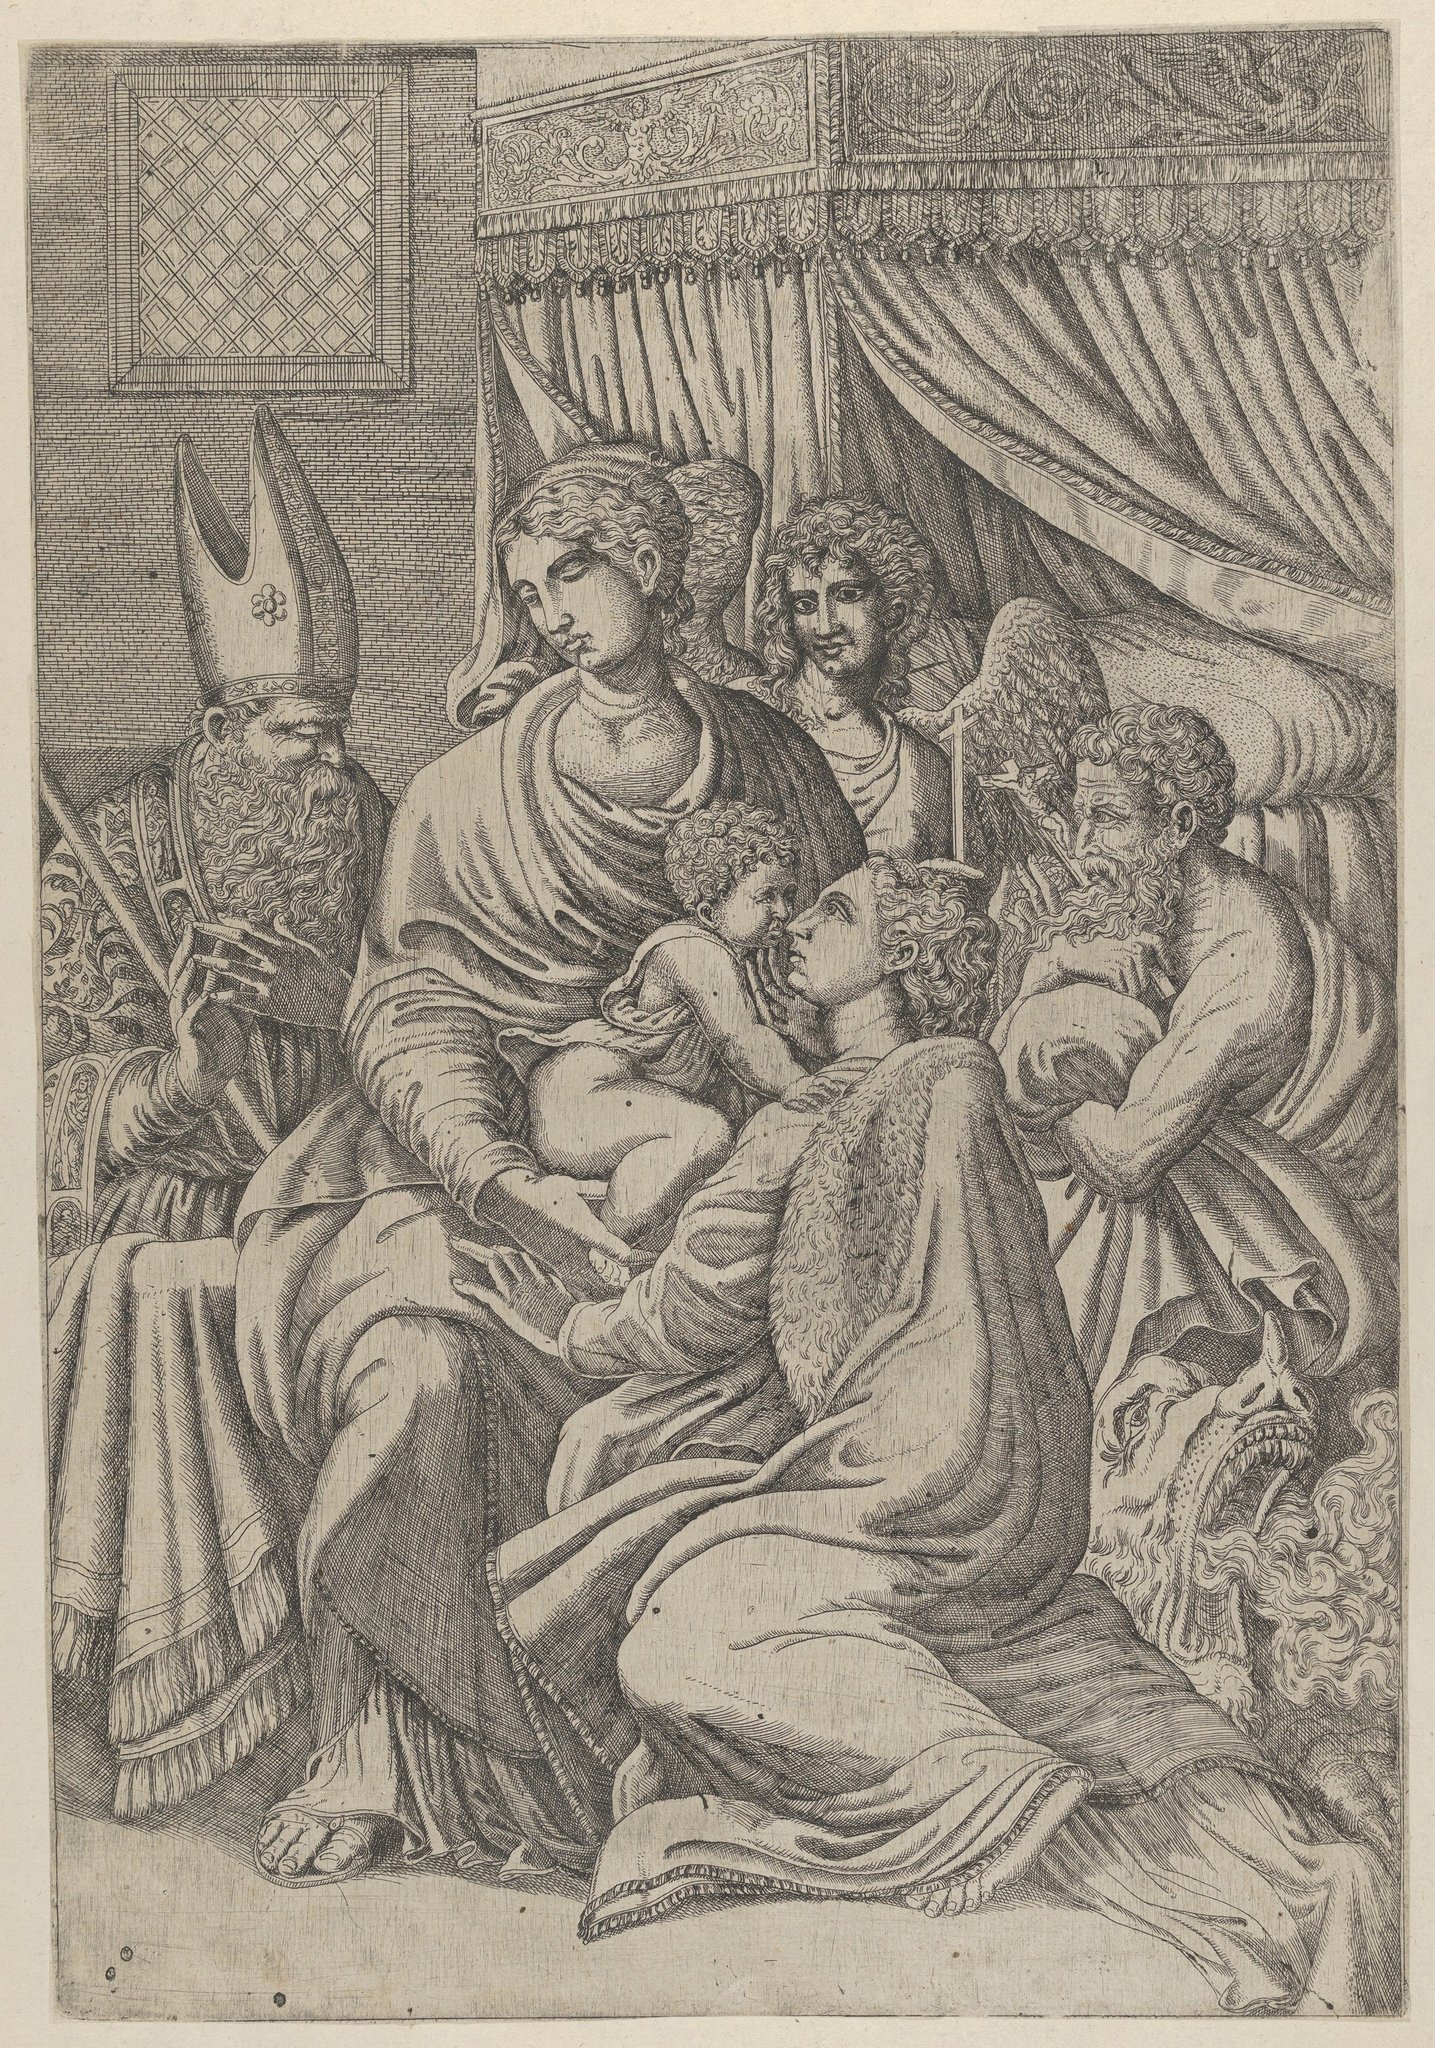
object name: print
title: Madonna of Saint Margaret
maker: master iqv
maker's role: artist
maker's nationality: french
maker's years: 1500-1600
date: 1543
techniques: etching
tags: men,women,angels,madonna and child,saints